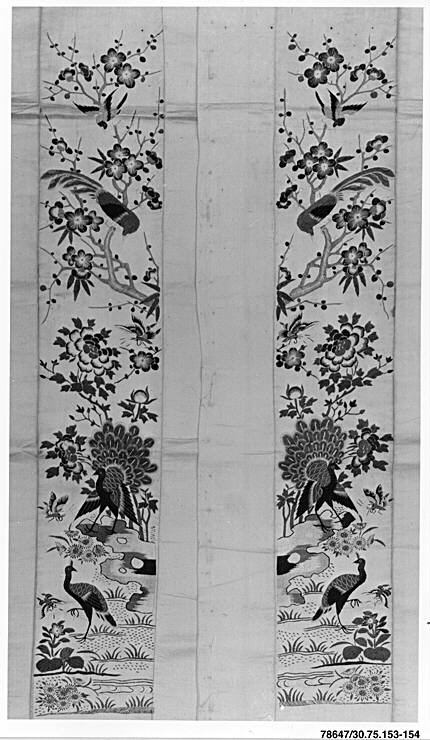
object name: sleeve band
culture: chinese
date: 1801-1900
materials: silk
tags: birds,peacocks,plants